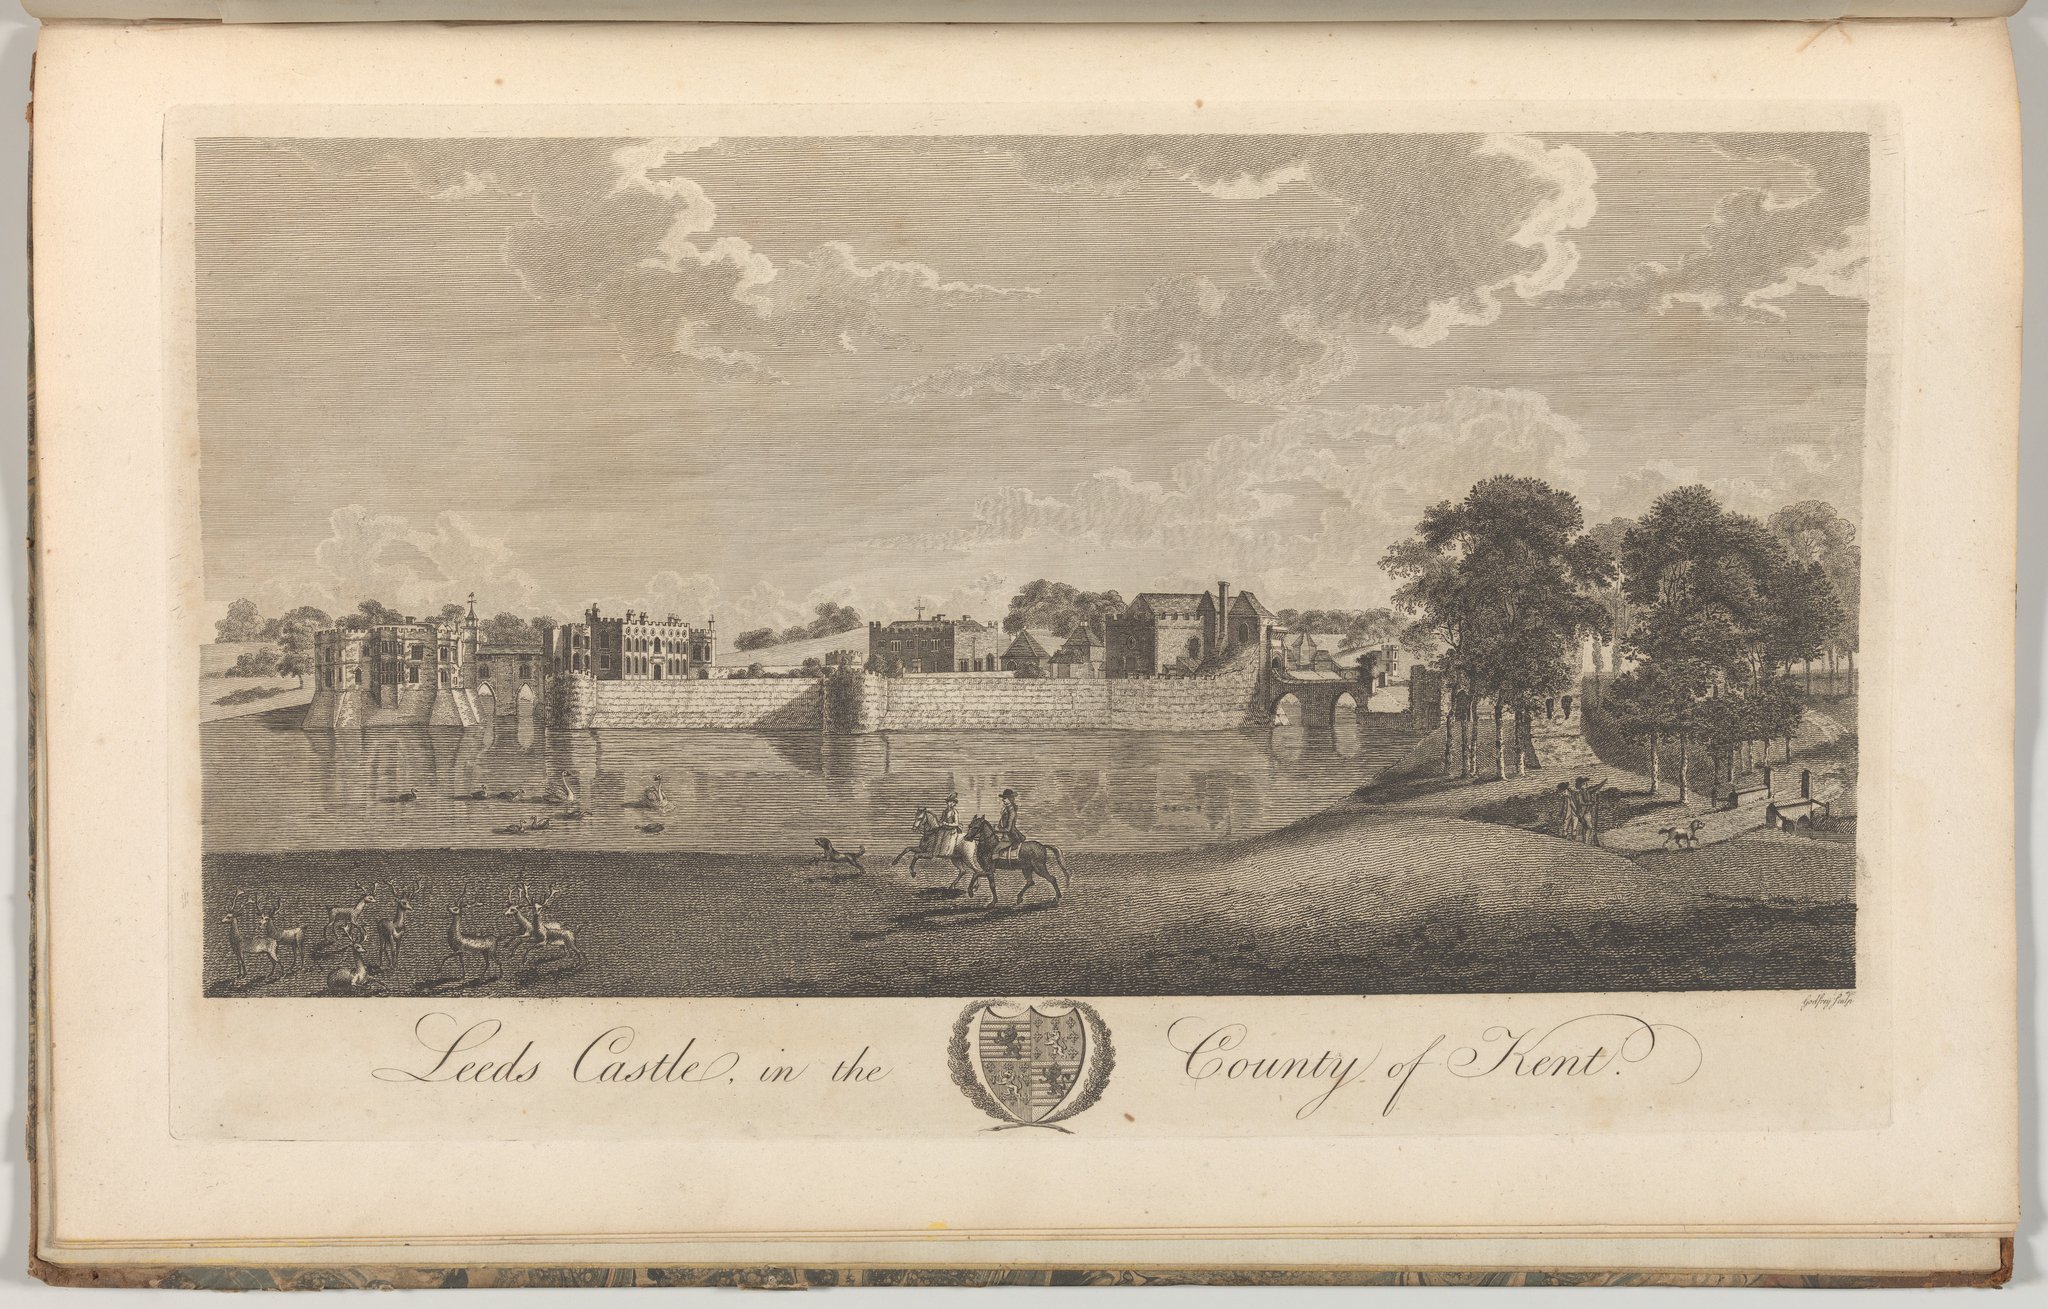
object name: print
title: Chilston in the County of Kent, from Edward Hasted's "The History and Topographical Survey of the County of Kent", vols. 1-3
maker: richard bernard godfrey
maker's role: artist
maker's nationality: british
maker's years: 1728-1795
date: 1777-1790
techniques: engraving, etching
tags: buildings,men,women,horses,coat of arms